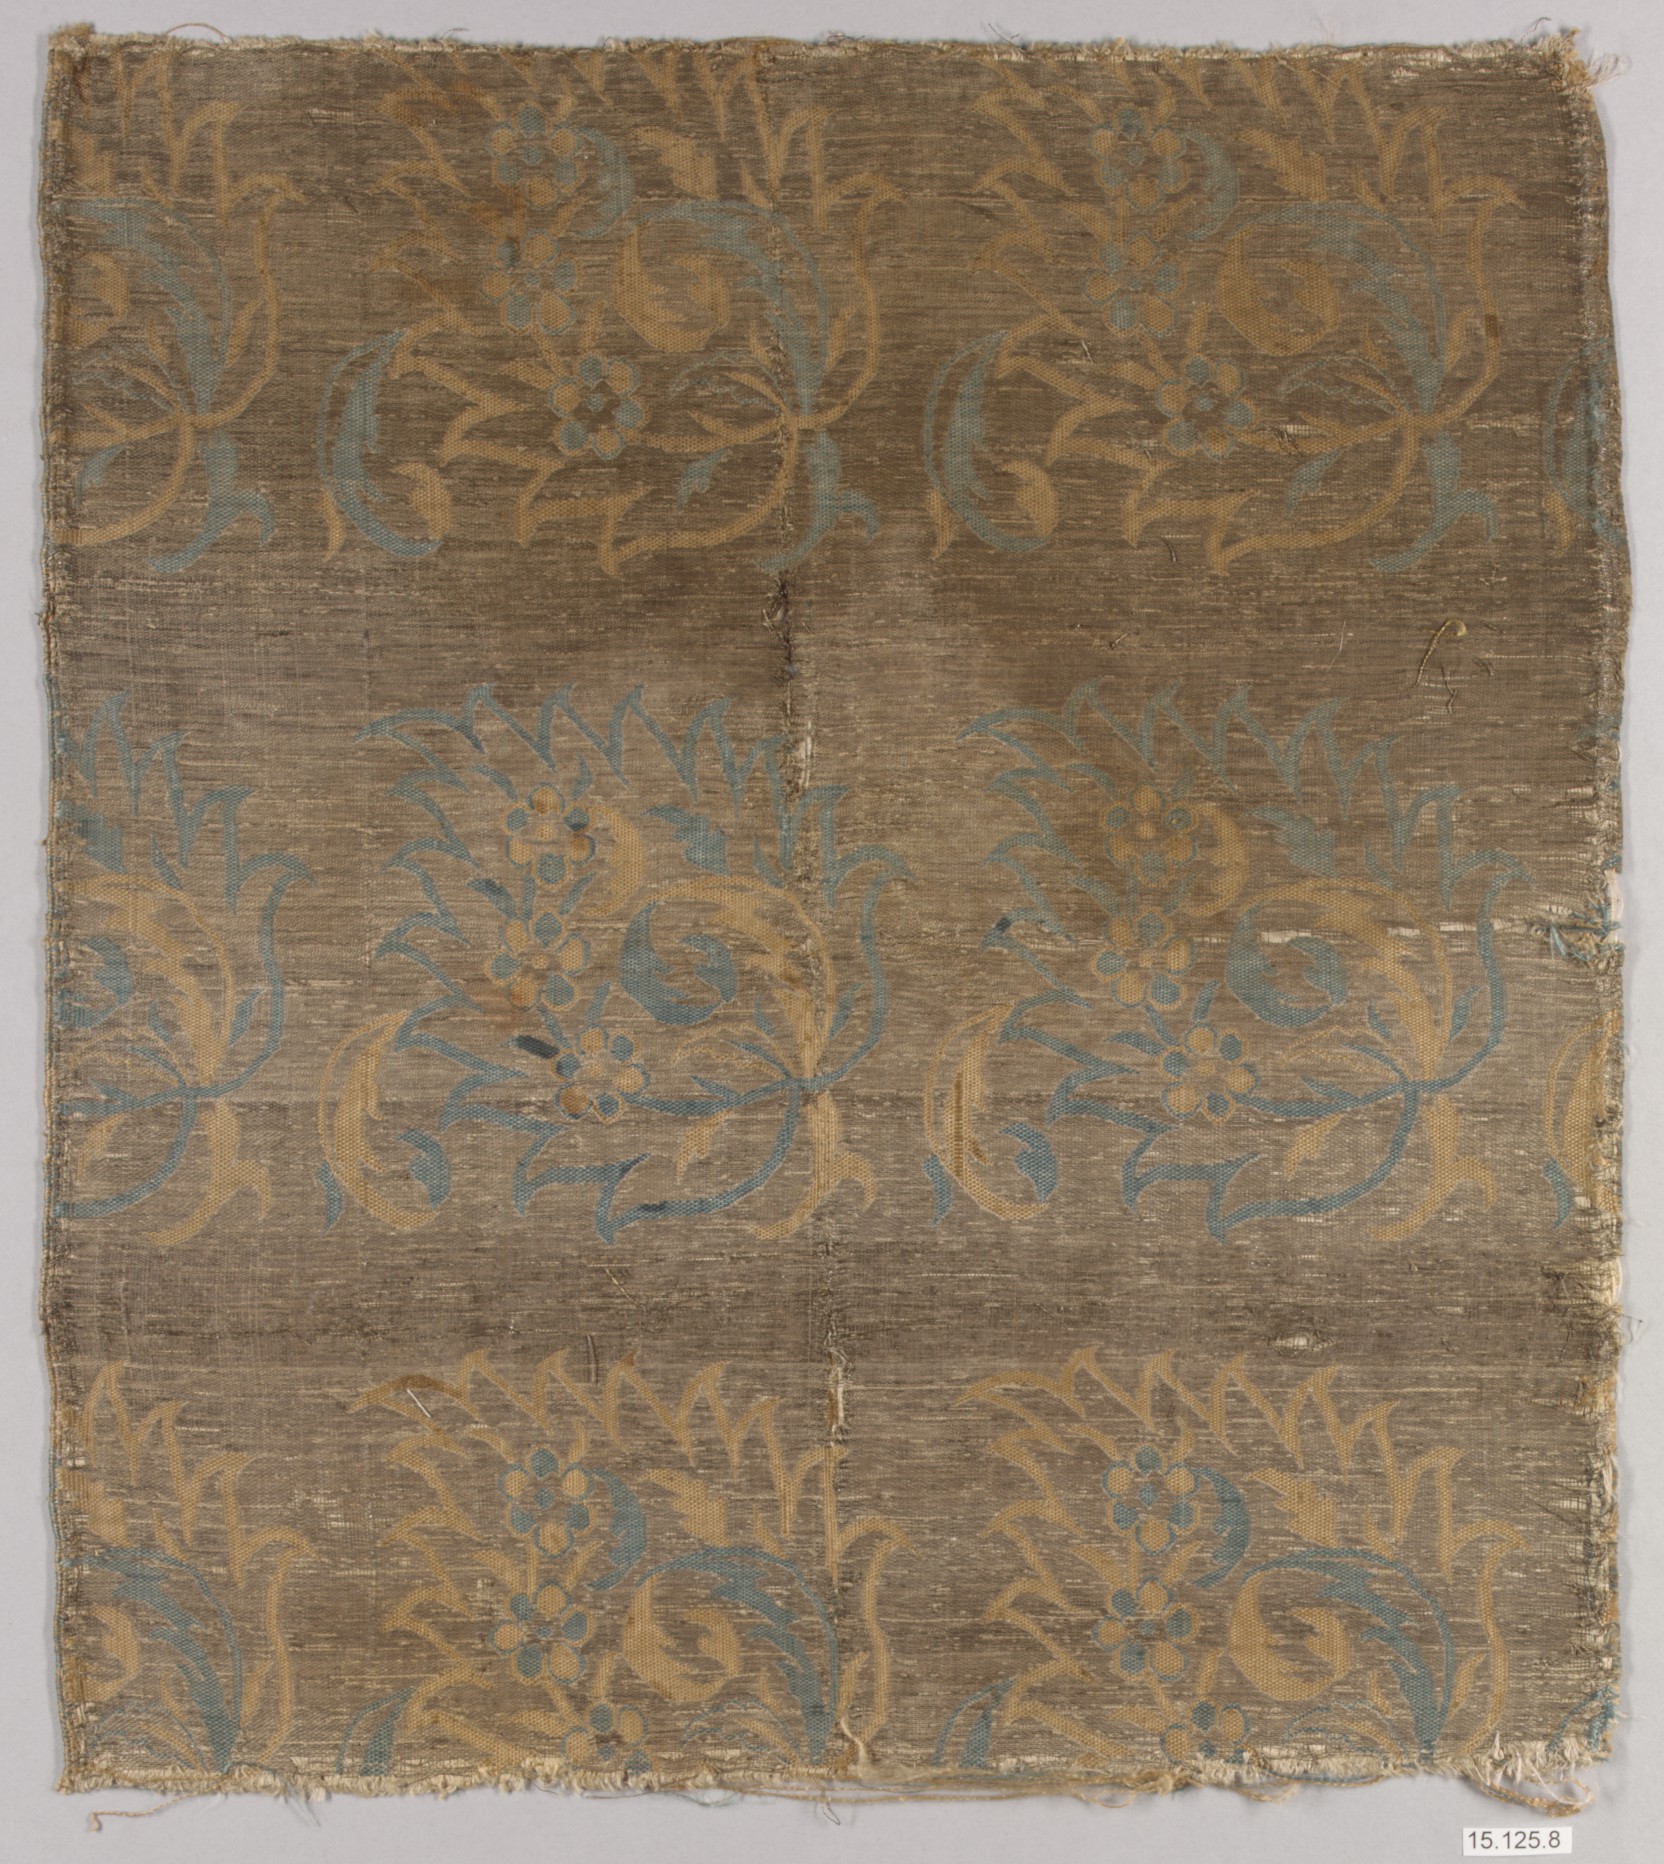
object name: textile fragment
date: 1601-1700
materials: silk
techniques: brocade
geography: iran